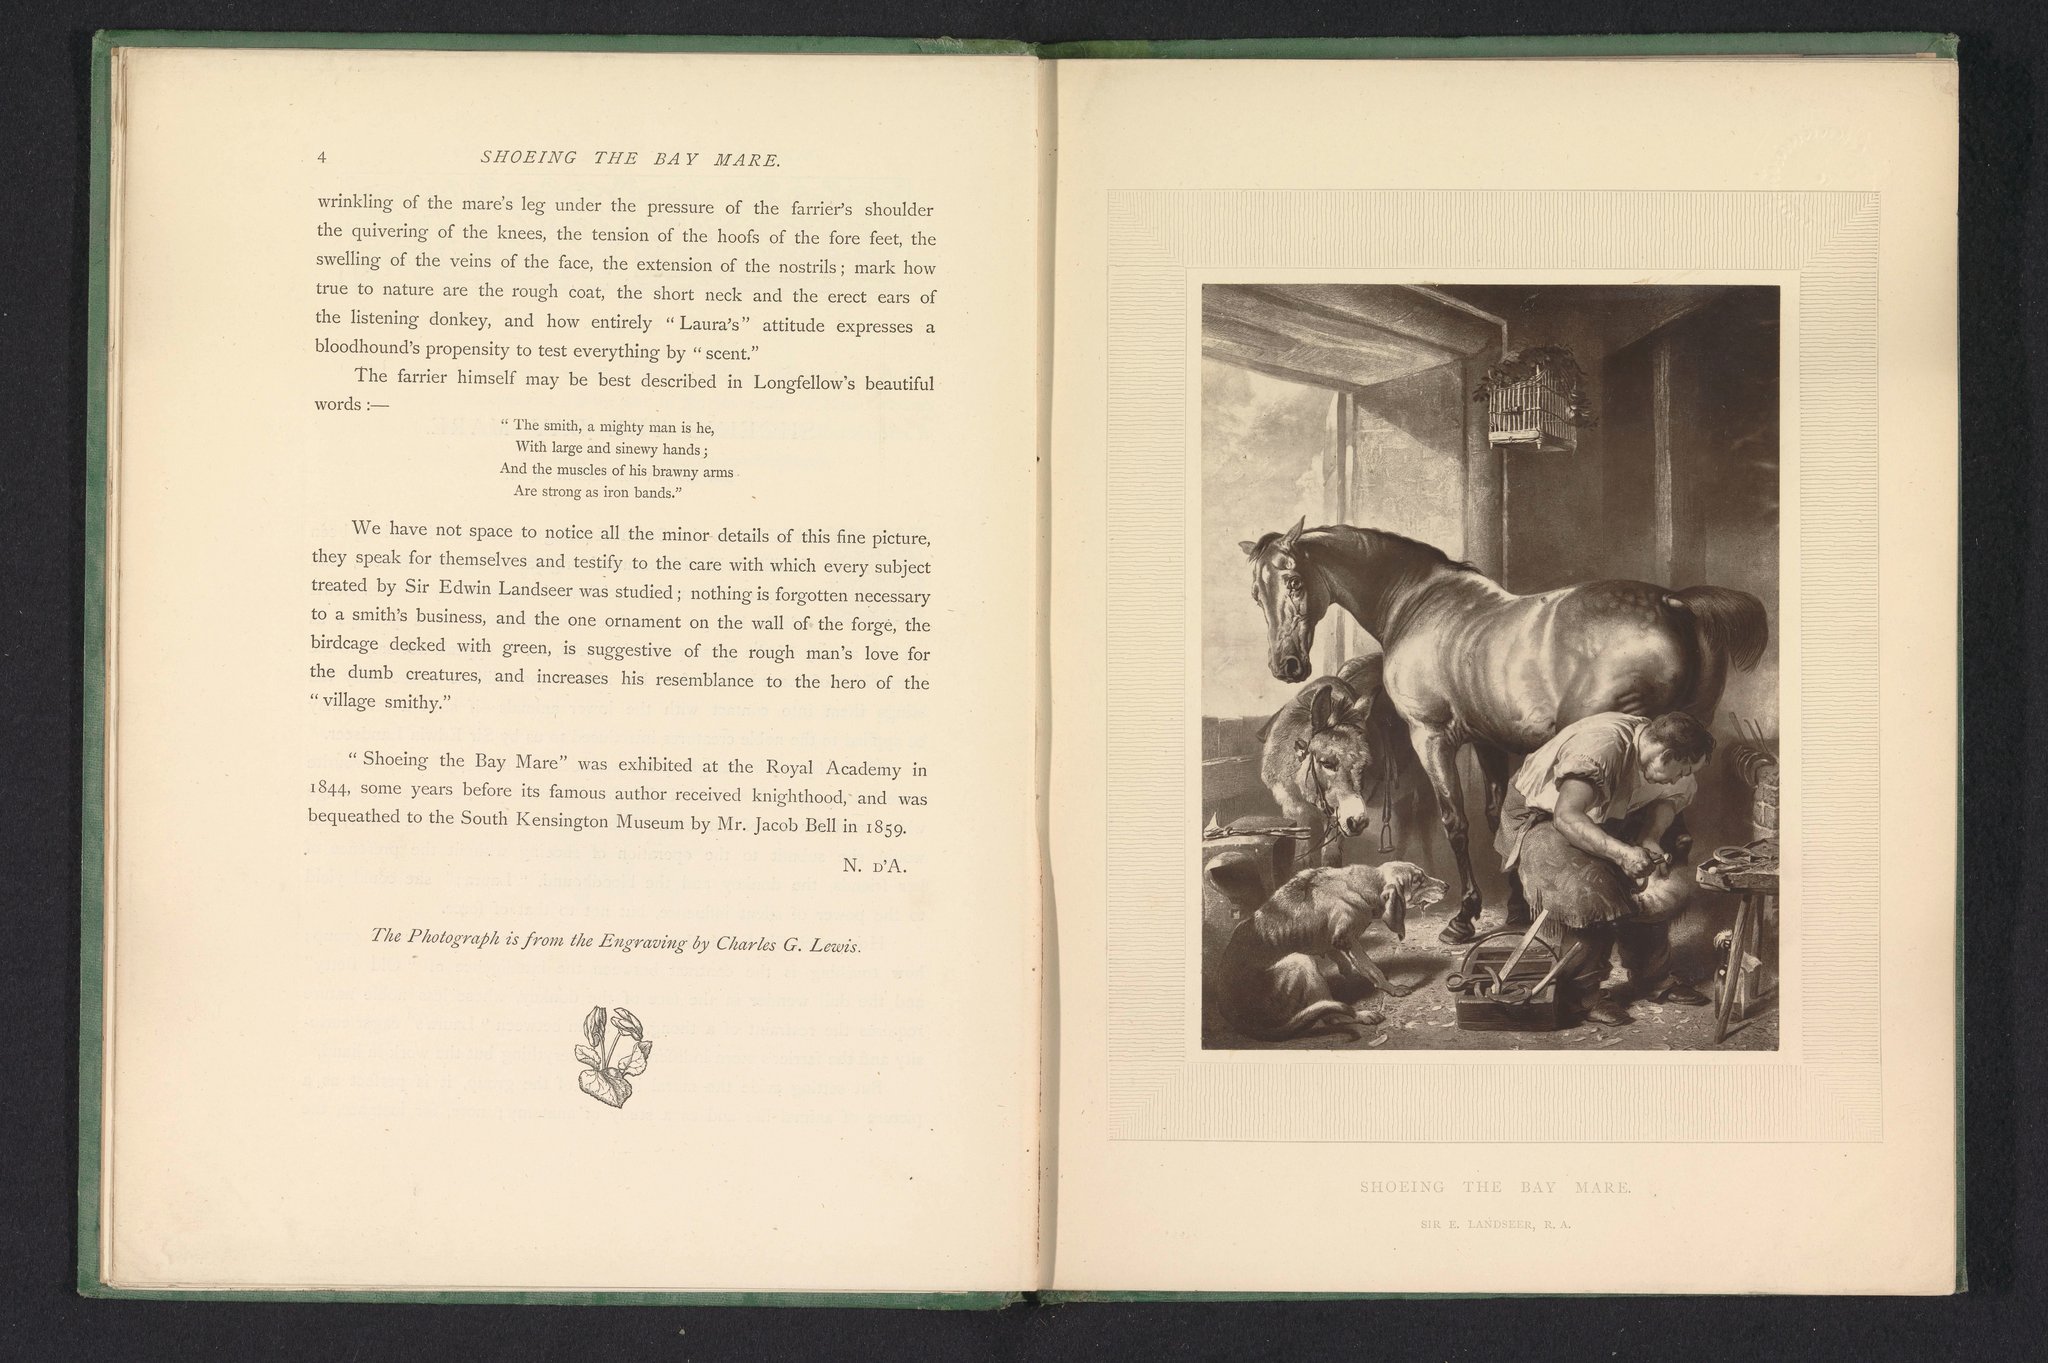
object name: page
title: Fotoreproductie van een prent naar een schilderij van een hoefsmid die een hoefijzer aanbrengt bij een paard in een stal door Edwin Henry Landseer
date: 1863-1873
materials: paper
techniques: woodburytype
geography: england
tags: horse, horseshoe